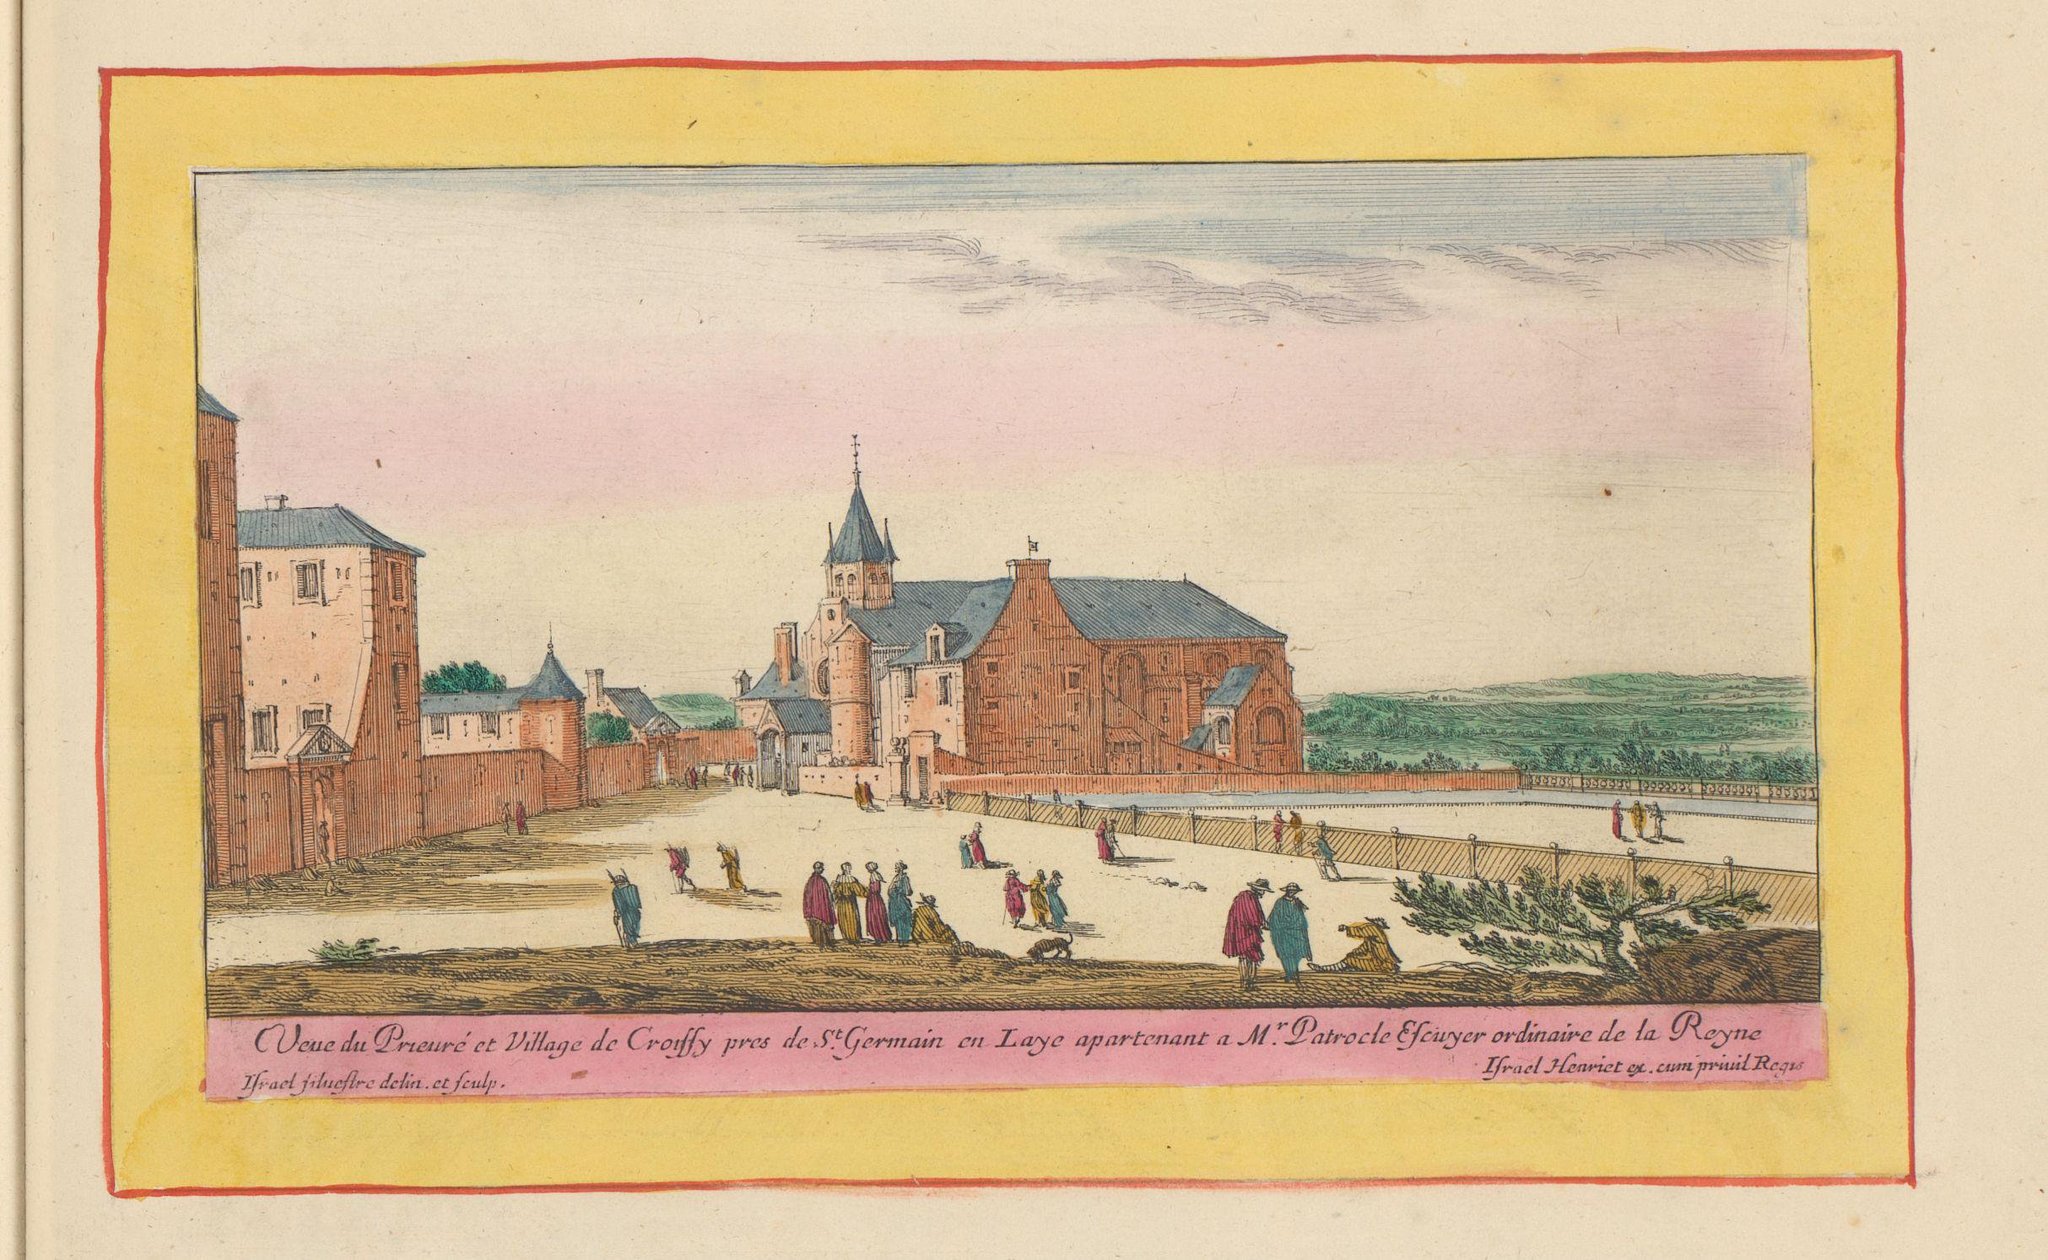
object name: print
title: Gezicht op het dorp en de priorij van Croissy-sur-Seine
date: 1631-1661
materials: paper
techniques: etching, hand coloring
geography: the hague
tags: village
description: Gezicht op het dorp en de priorij van Croissy-sur-Seine. Prent maakt deel uit van een album.